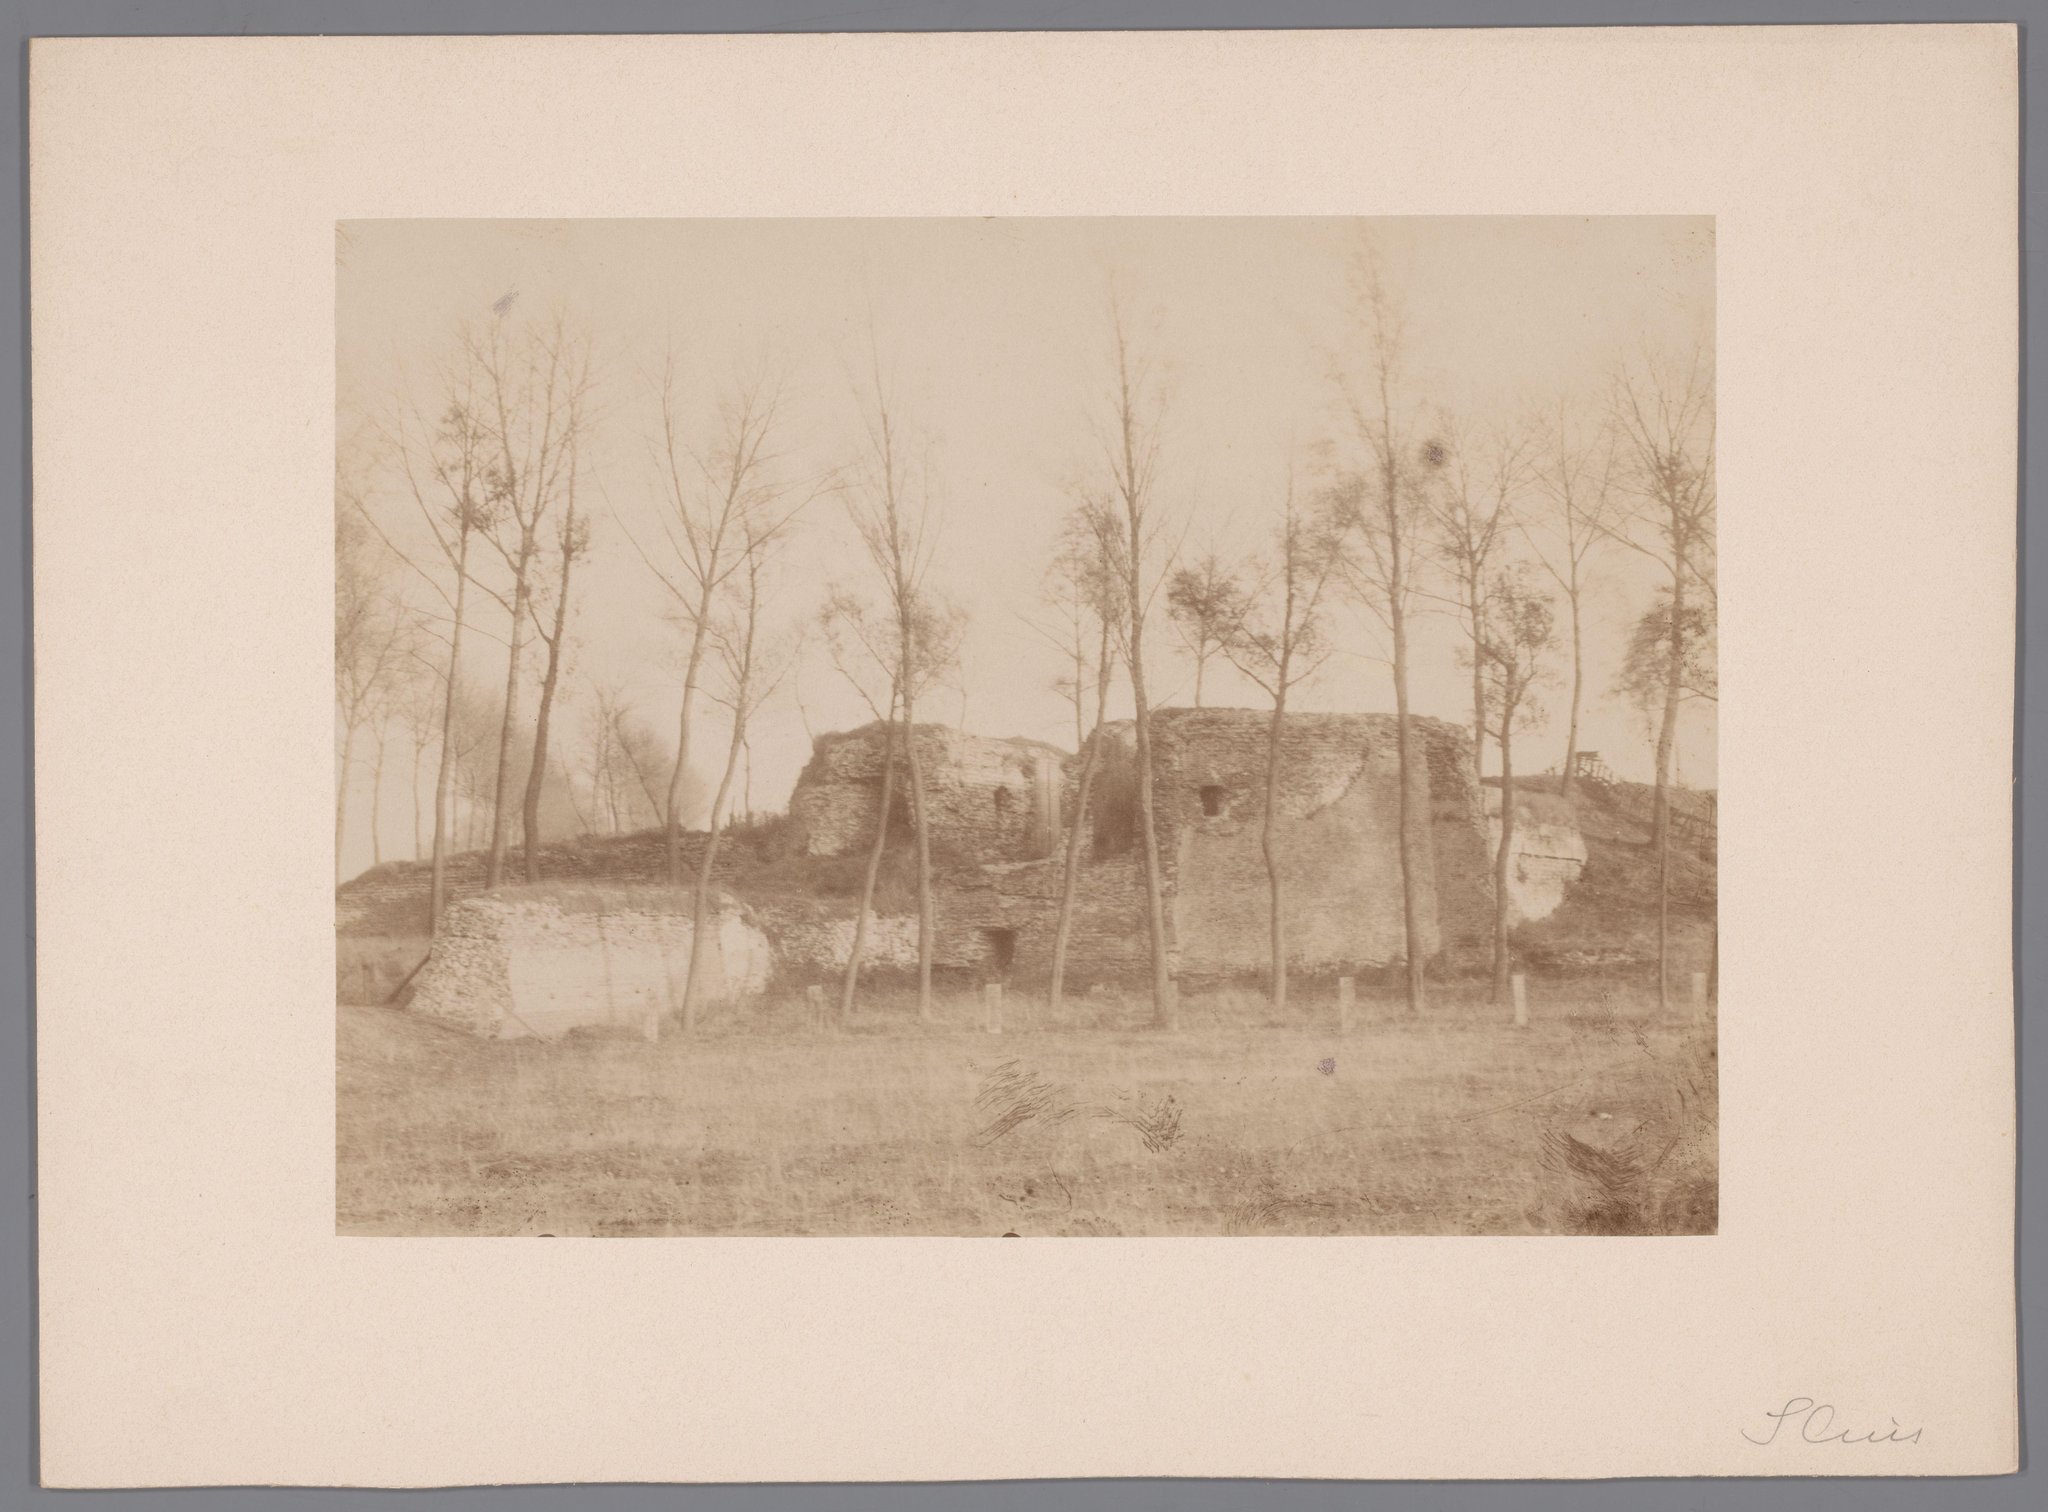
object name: photograph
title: Restanten van de Stenen Beer of Westpoort te Sluis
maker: anoniem (monumentenzorg)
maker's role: fotograaf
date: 1902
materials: cardboard, photographic support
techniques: albumen print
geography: sluis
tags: landscape with ruins, gate, entrance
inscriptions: annotation: ‘Sluis’, annotation: ‘Sluis (Z.)/ overblijfselen der Westpoort/ Nov 1902’